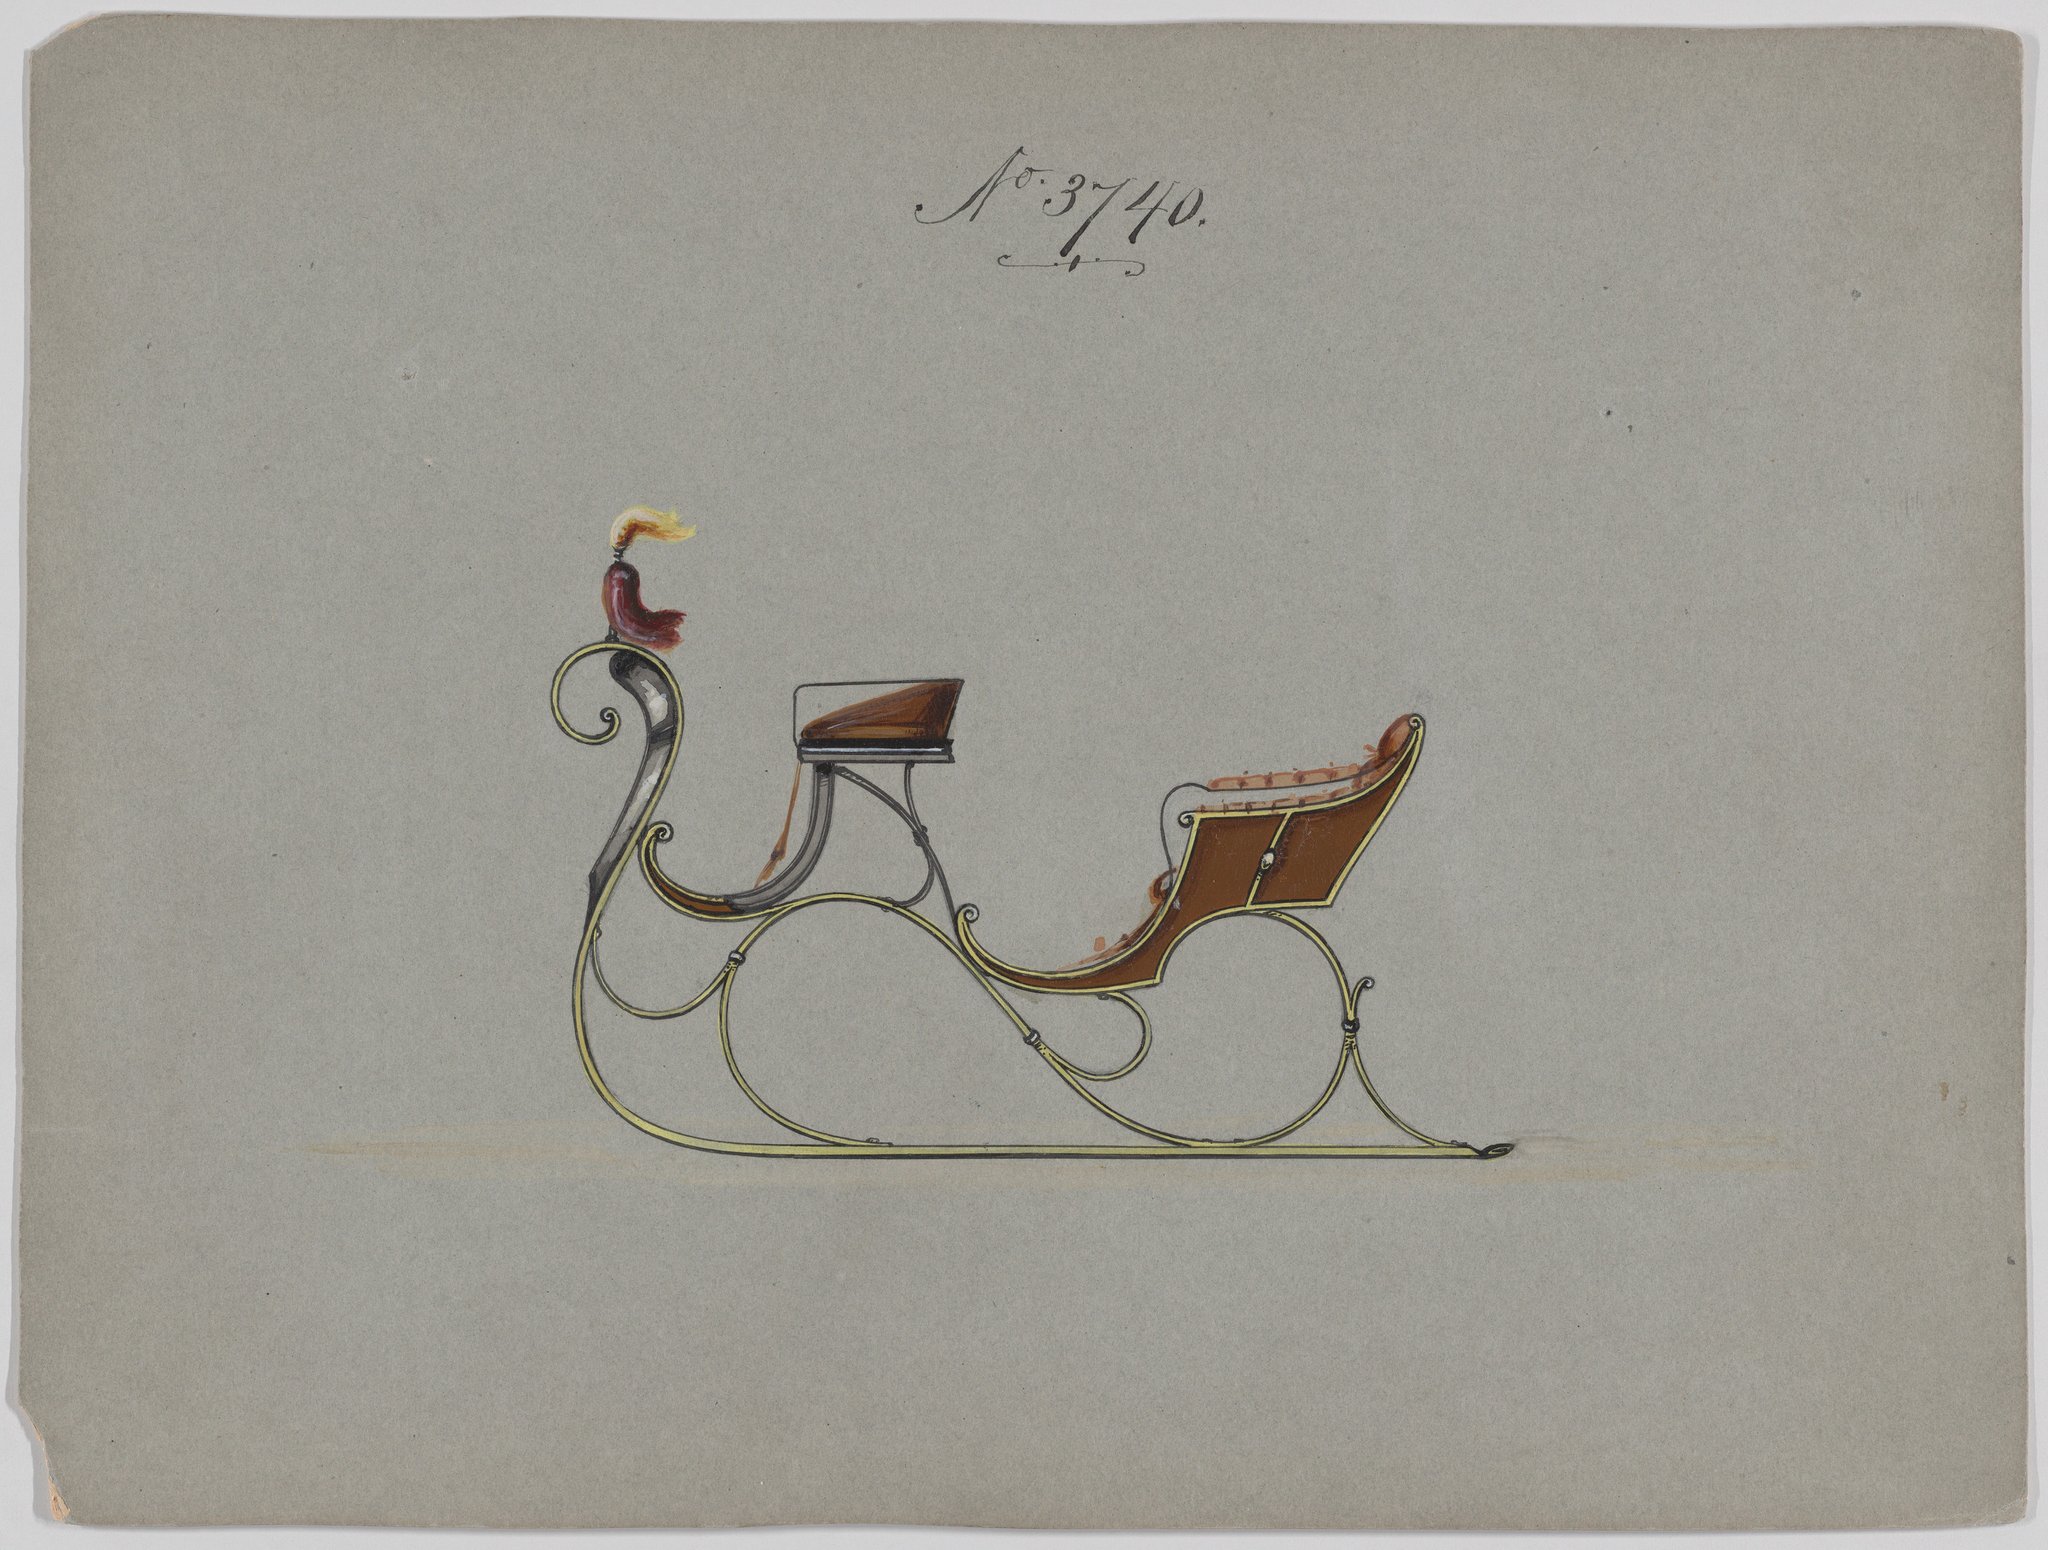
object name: drawing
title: Design for 4 Seat Sleigh, no. 3740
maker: brewster & co.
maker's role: manufacturer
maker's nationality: american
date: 1882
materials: gouache, gum arabic, ink, watercolor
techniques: pen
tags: sleighs